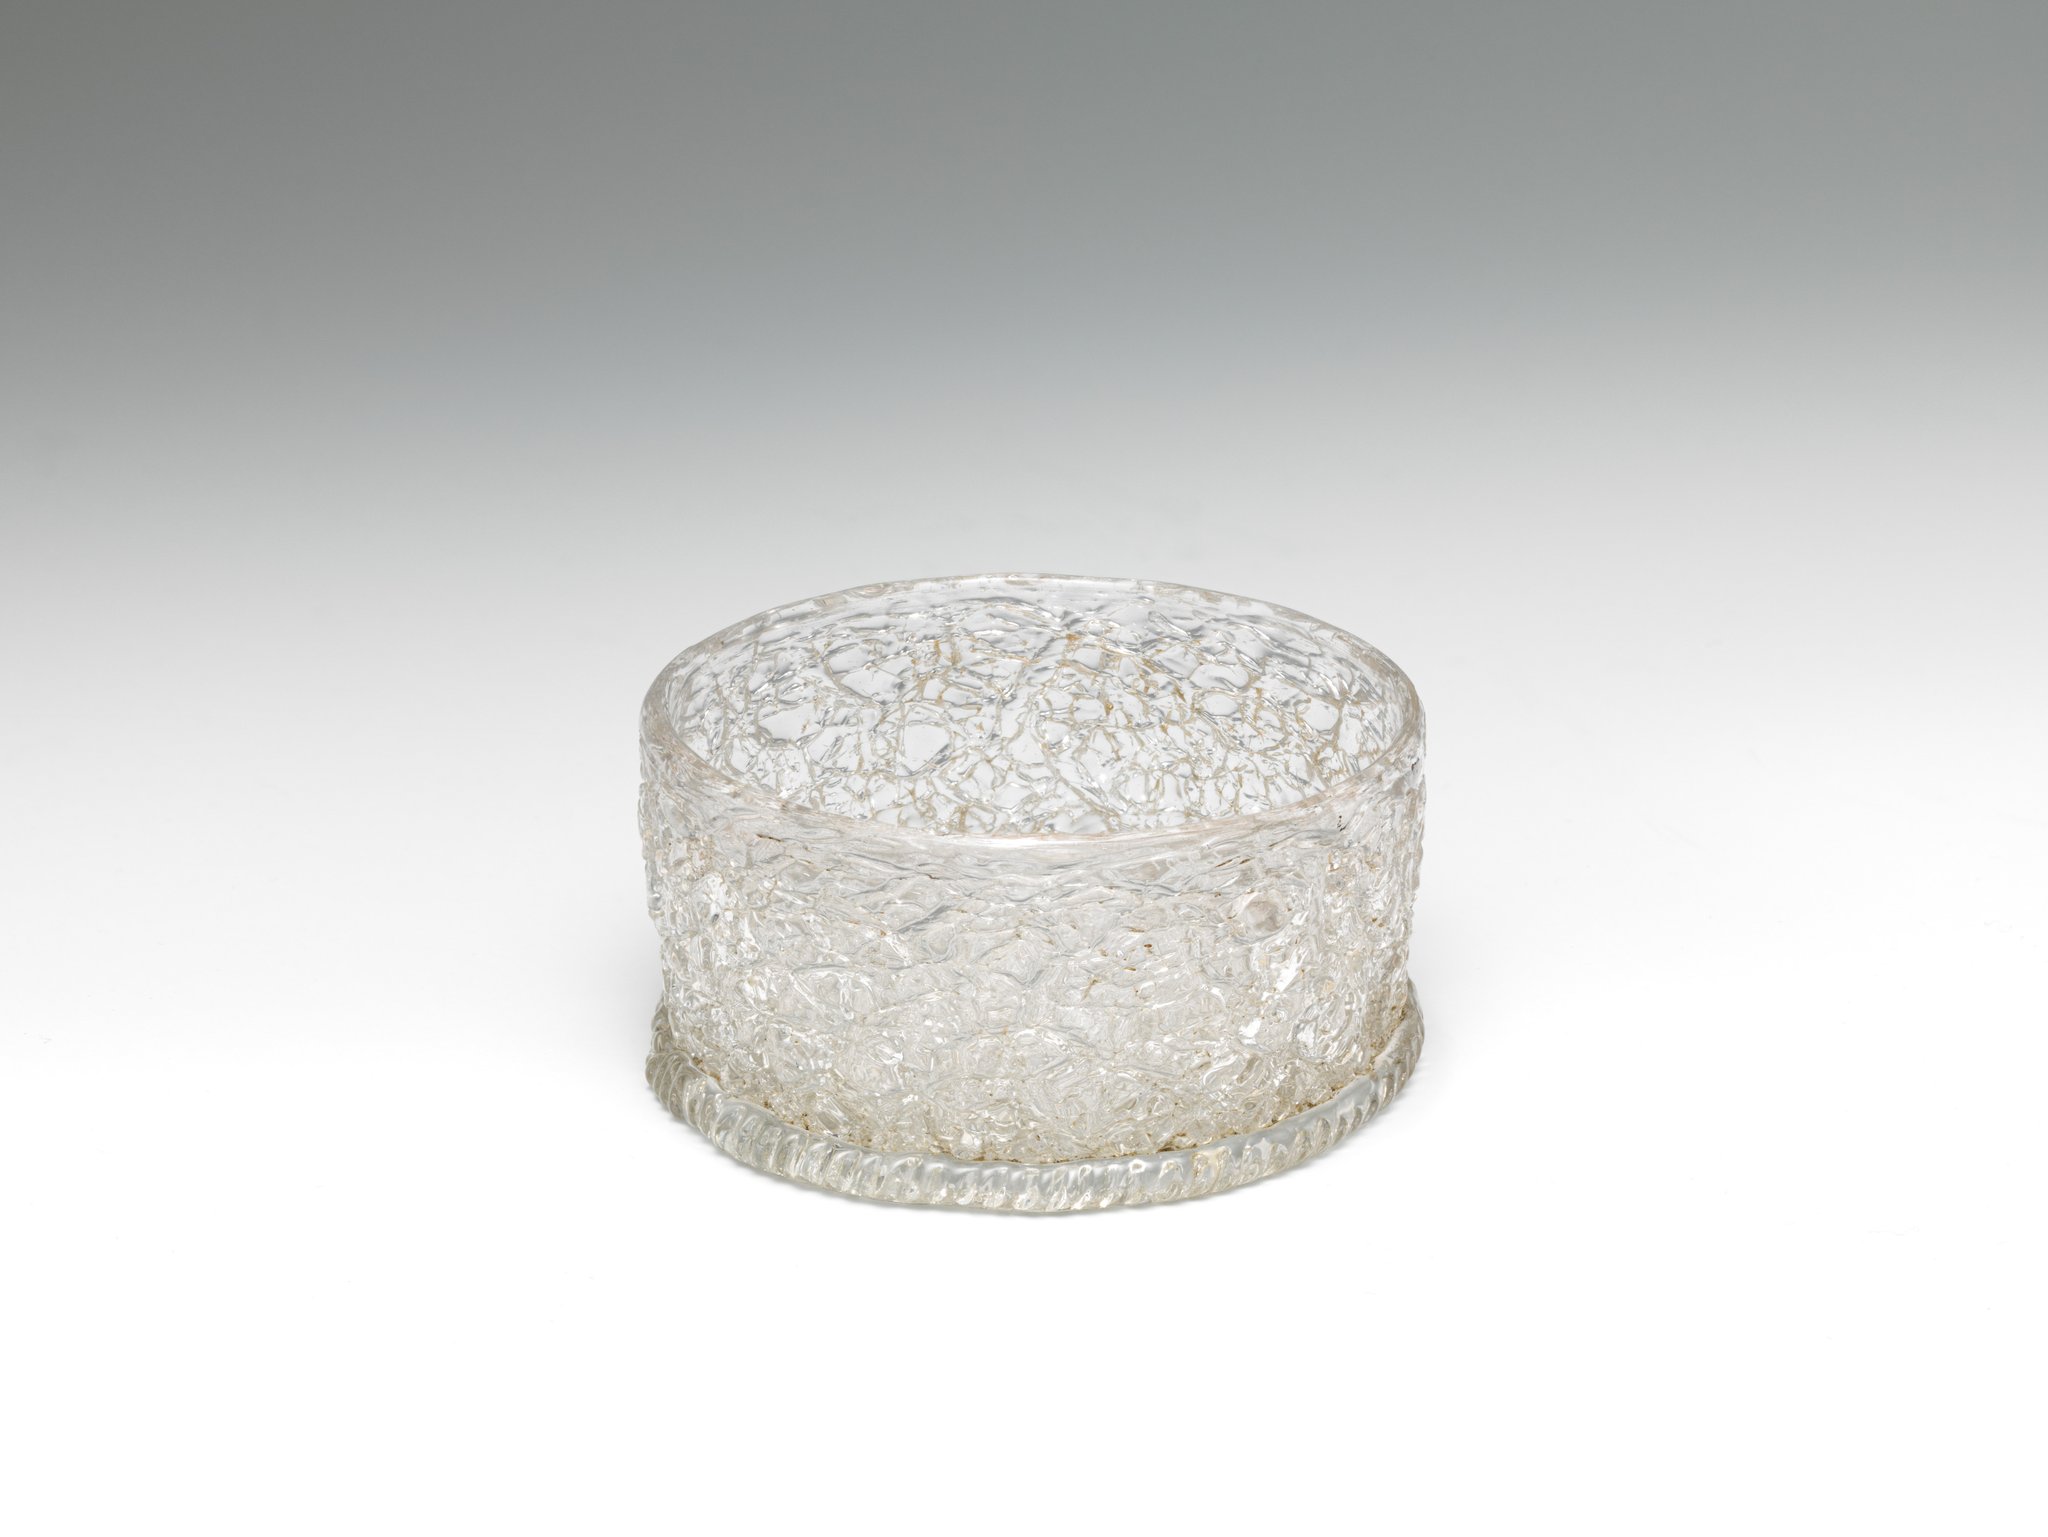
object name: saltcellar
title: Saltcellar (?)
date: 1701-1900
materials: glass